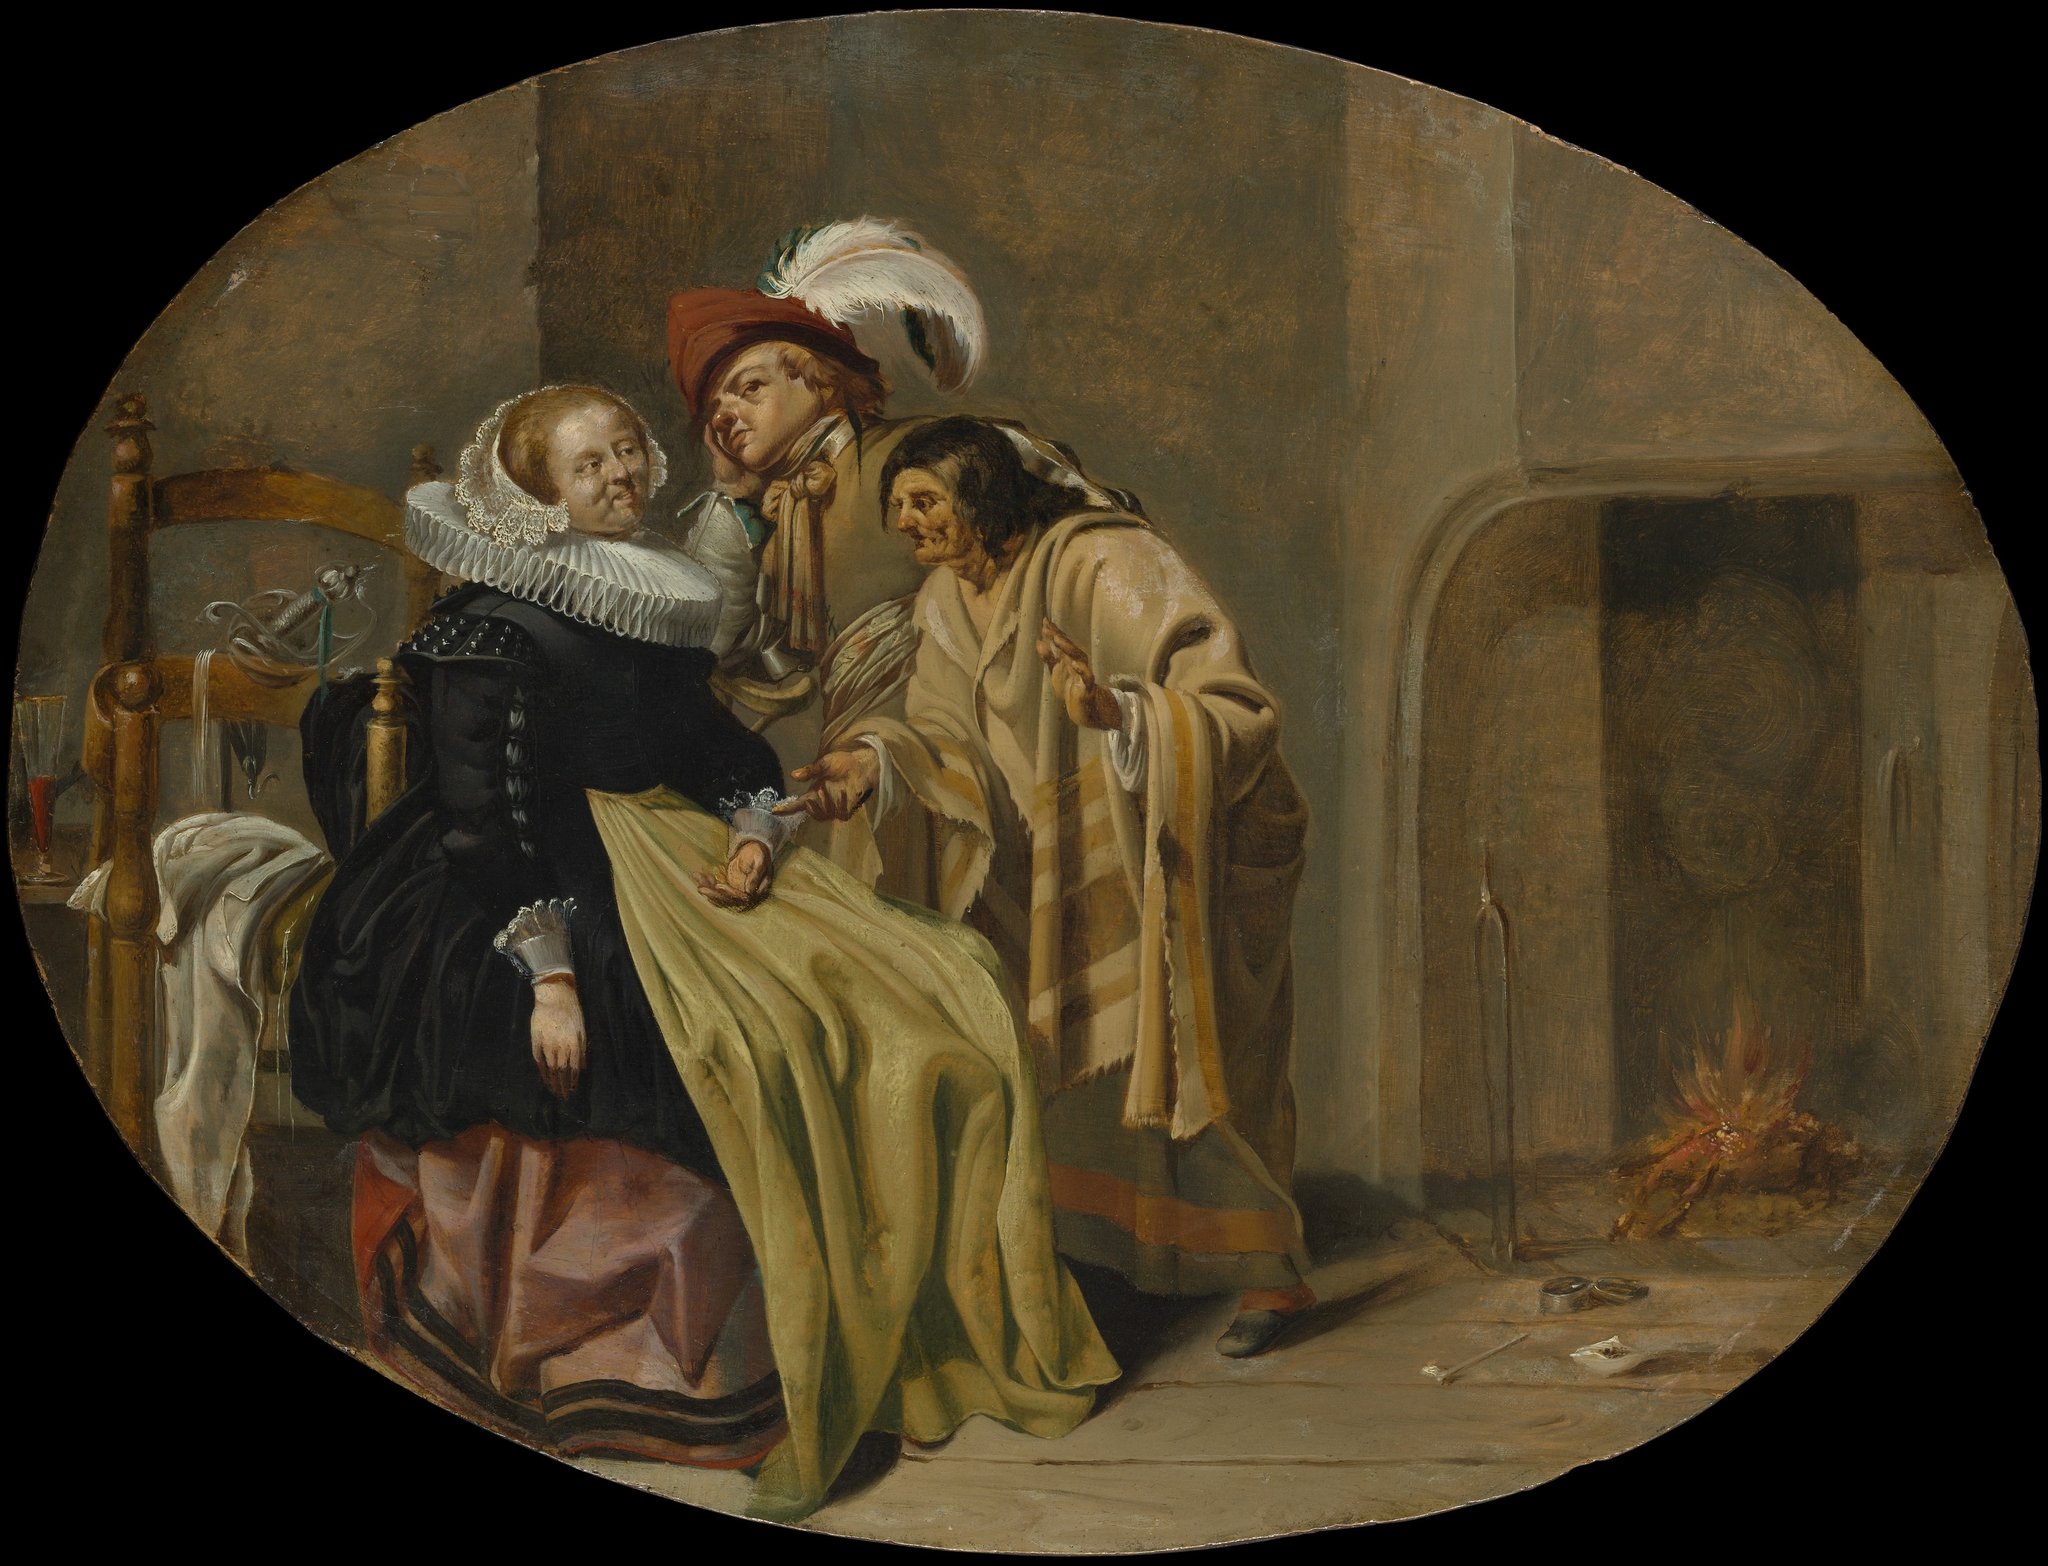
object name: painting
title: A Couple in an Interior with a Fortune-Teller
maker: jacob duck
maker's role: artist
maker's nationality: dutch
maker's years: 1598-1667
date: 1632-1633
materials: oil, wood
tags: fireplaces,interiors,couples,men,women